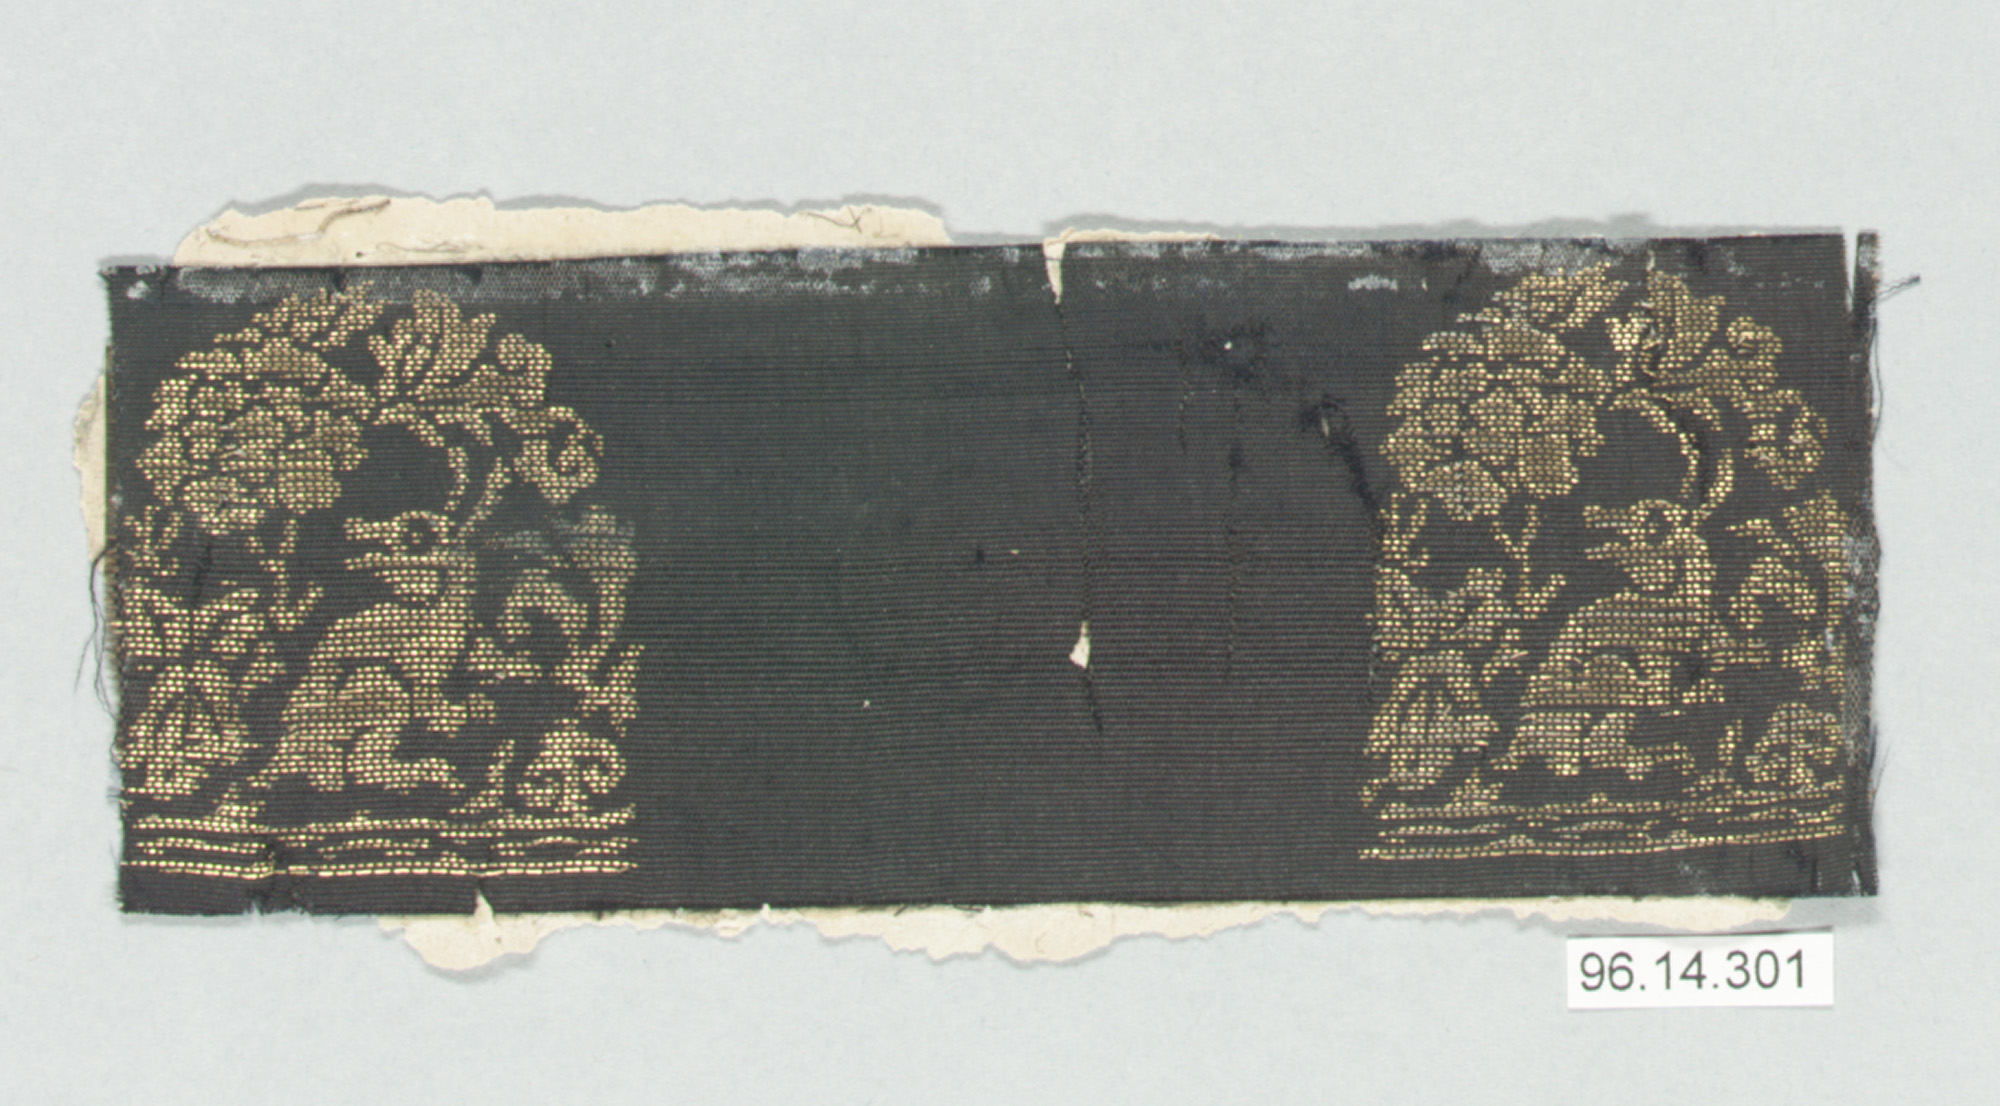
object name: piece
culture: japanese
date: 1801-1900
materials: metal thread, silk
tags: rabbits